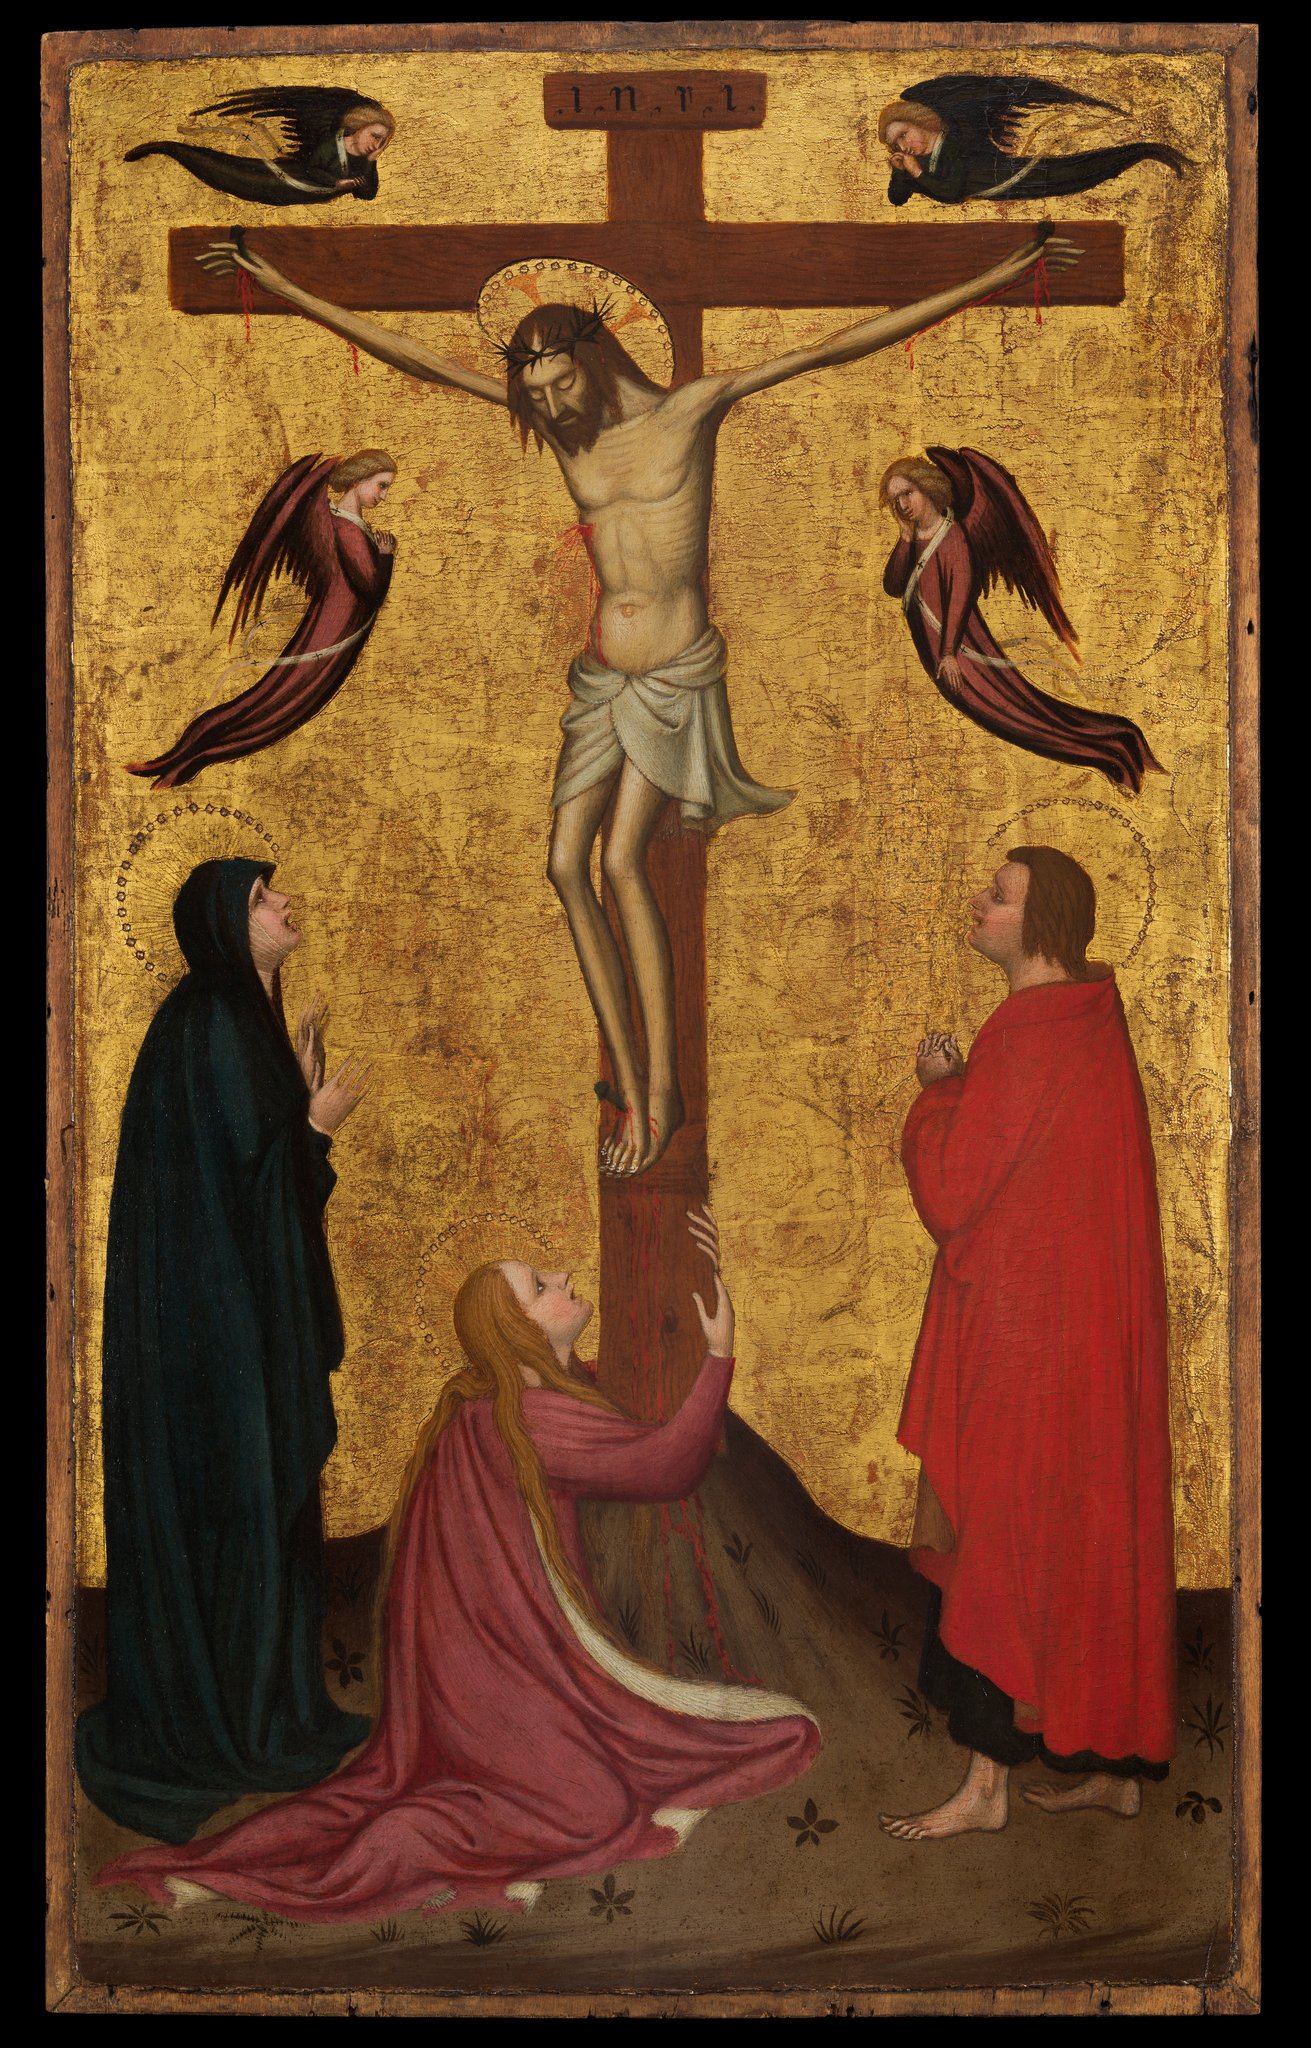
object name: painting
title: The Crucifixion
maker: stefano da verona (stefano di giovanni d'arbosio di francia)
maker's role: artist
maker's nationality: italian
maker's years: 1374-1438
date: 1400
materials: gold leaf, paint, wood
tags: angels,christ,mary magdalene,virgin mary,crucifixion